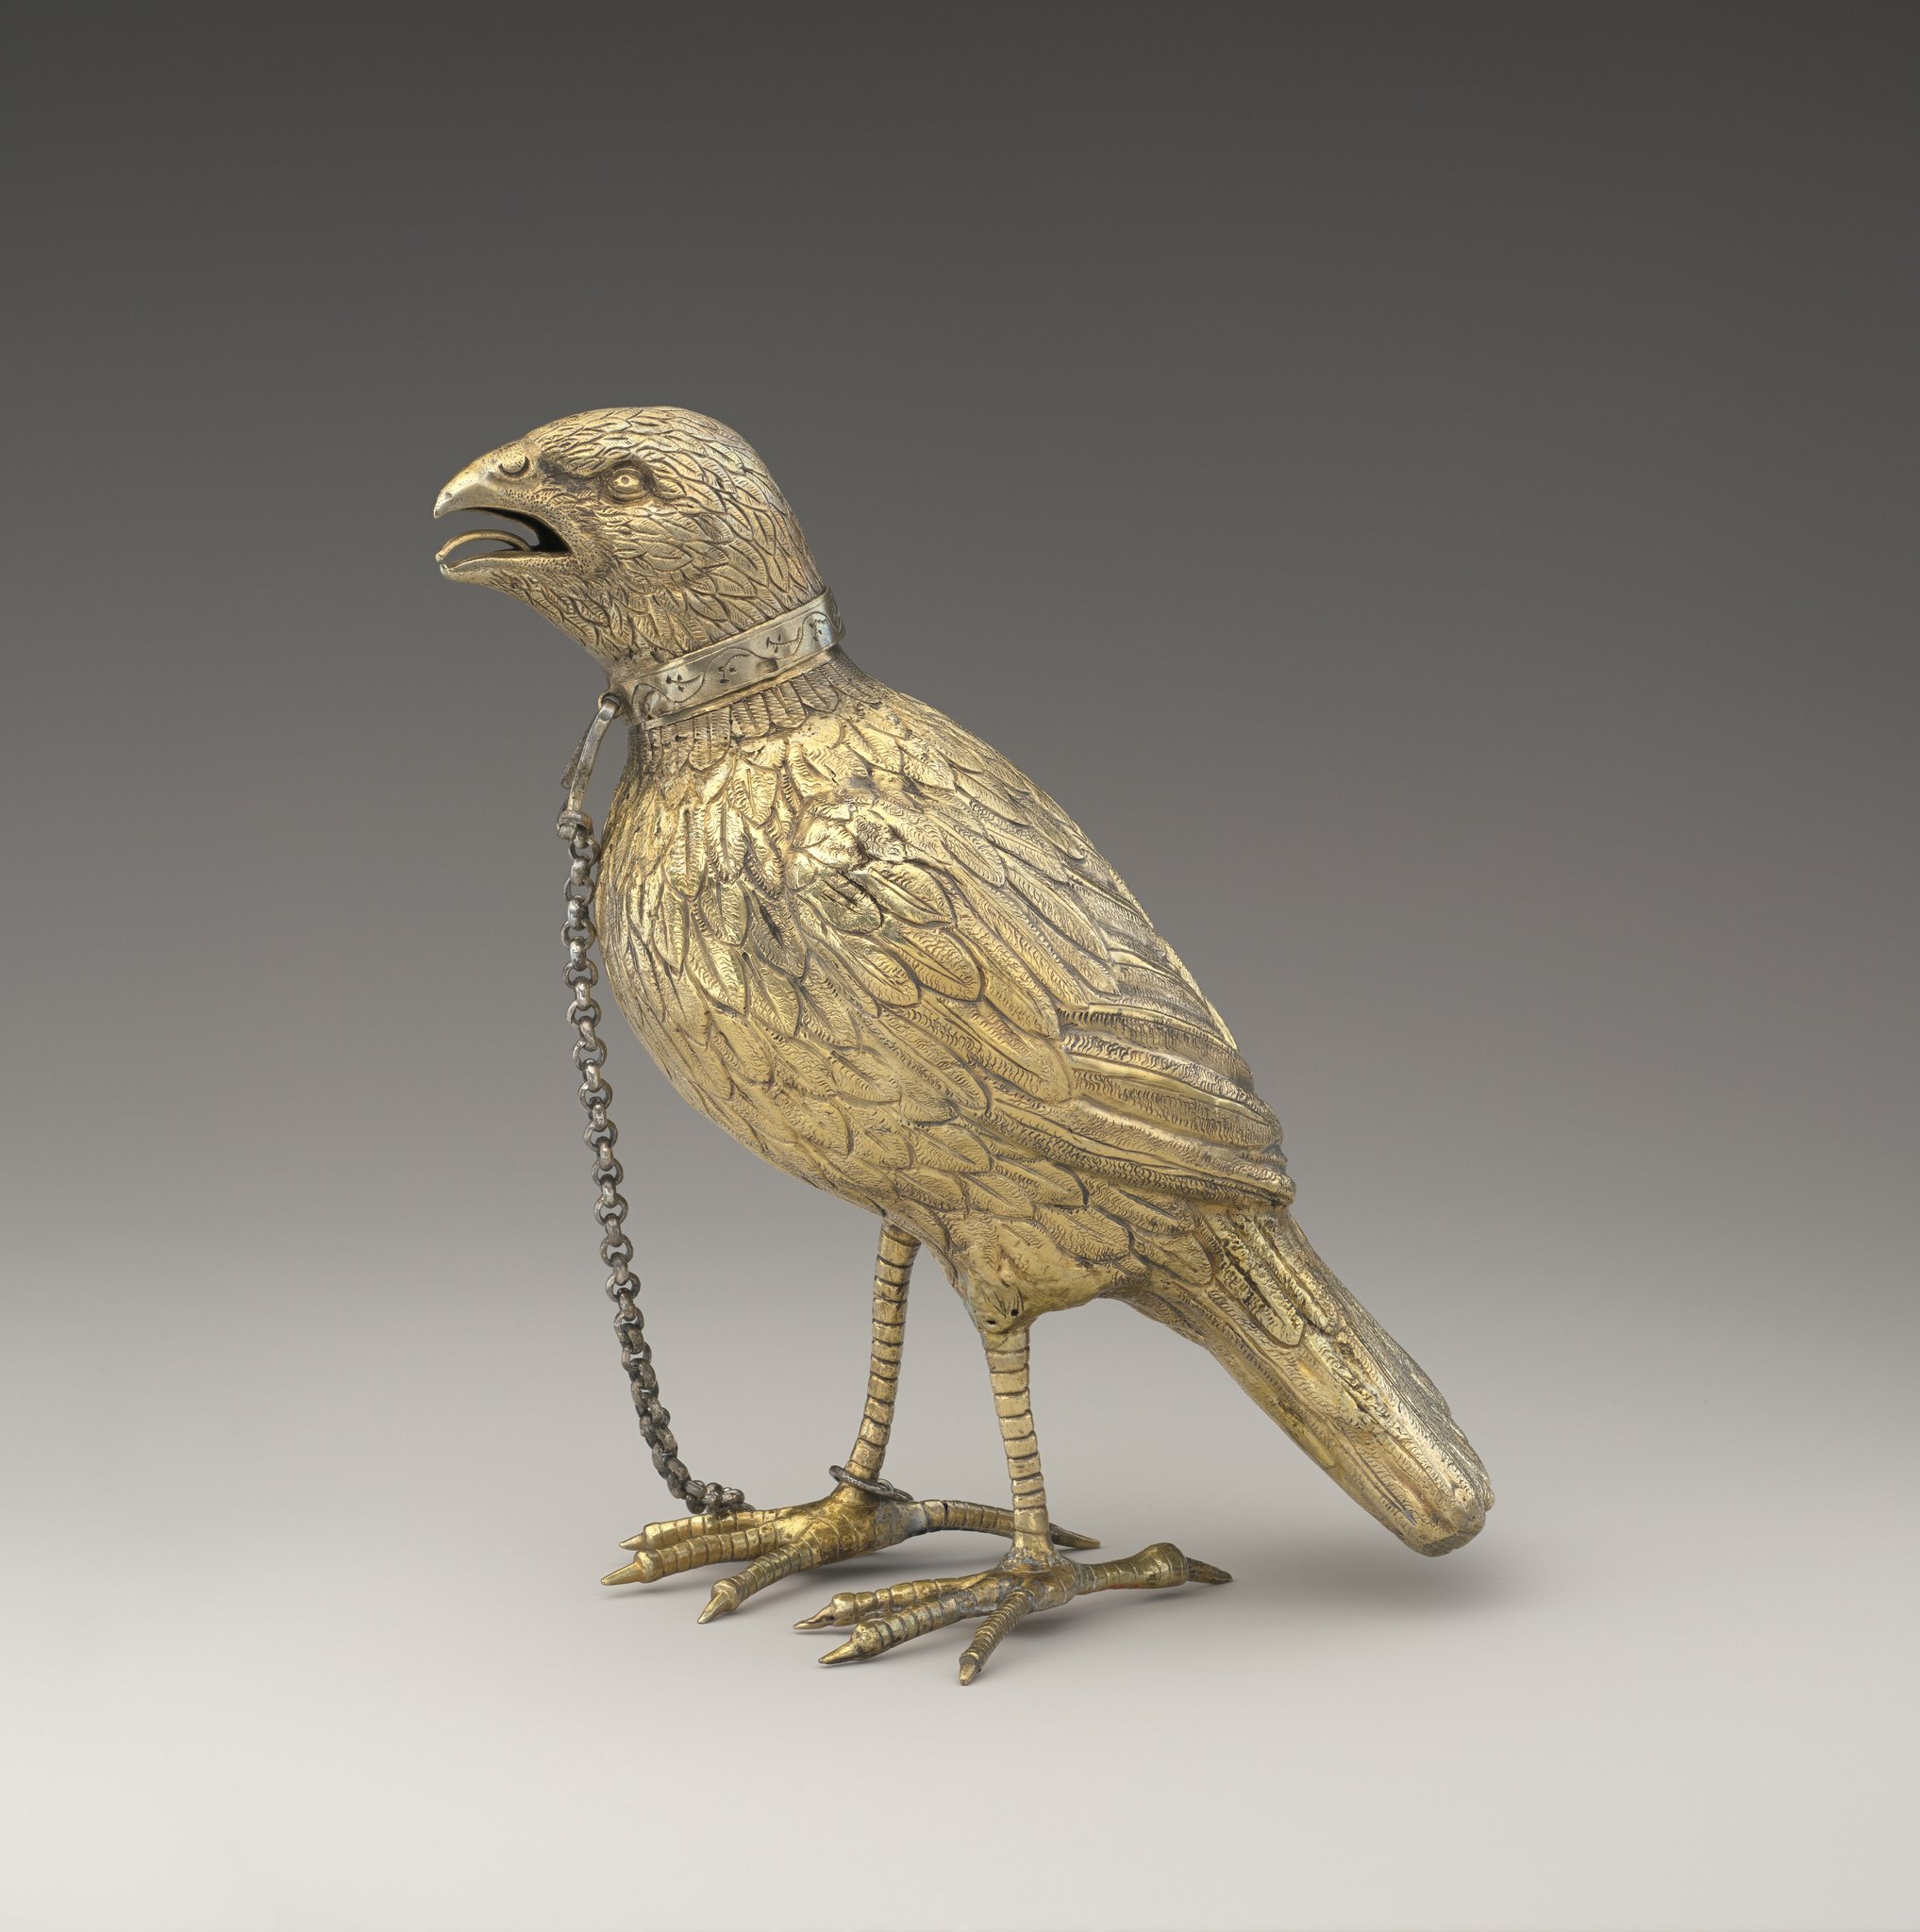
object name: cup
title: Cup in the form of a lark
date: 1601-1700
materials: gilt silver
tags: birds